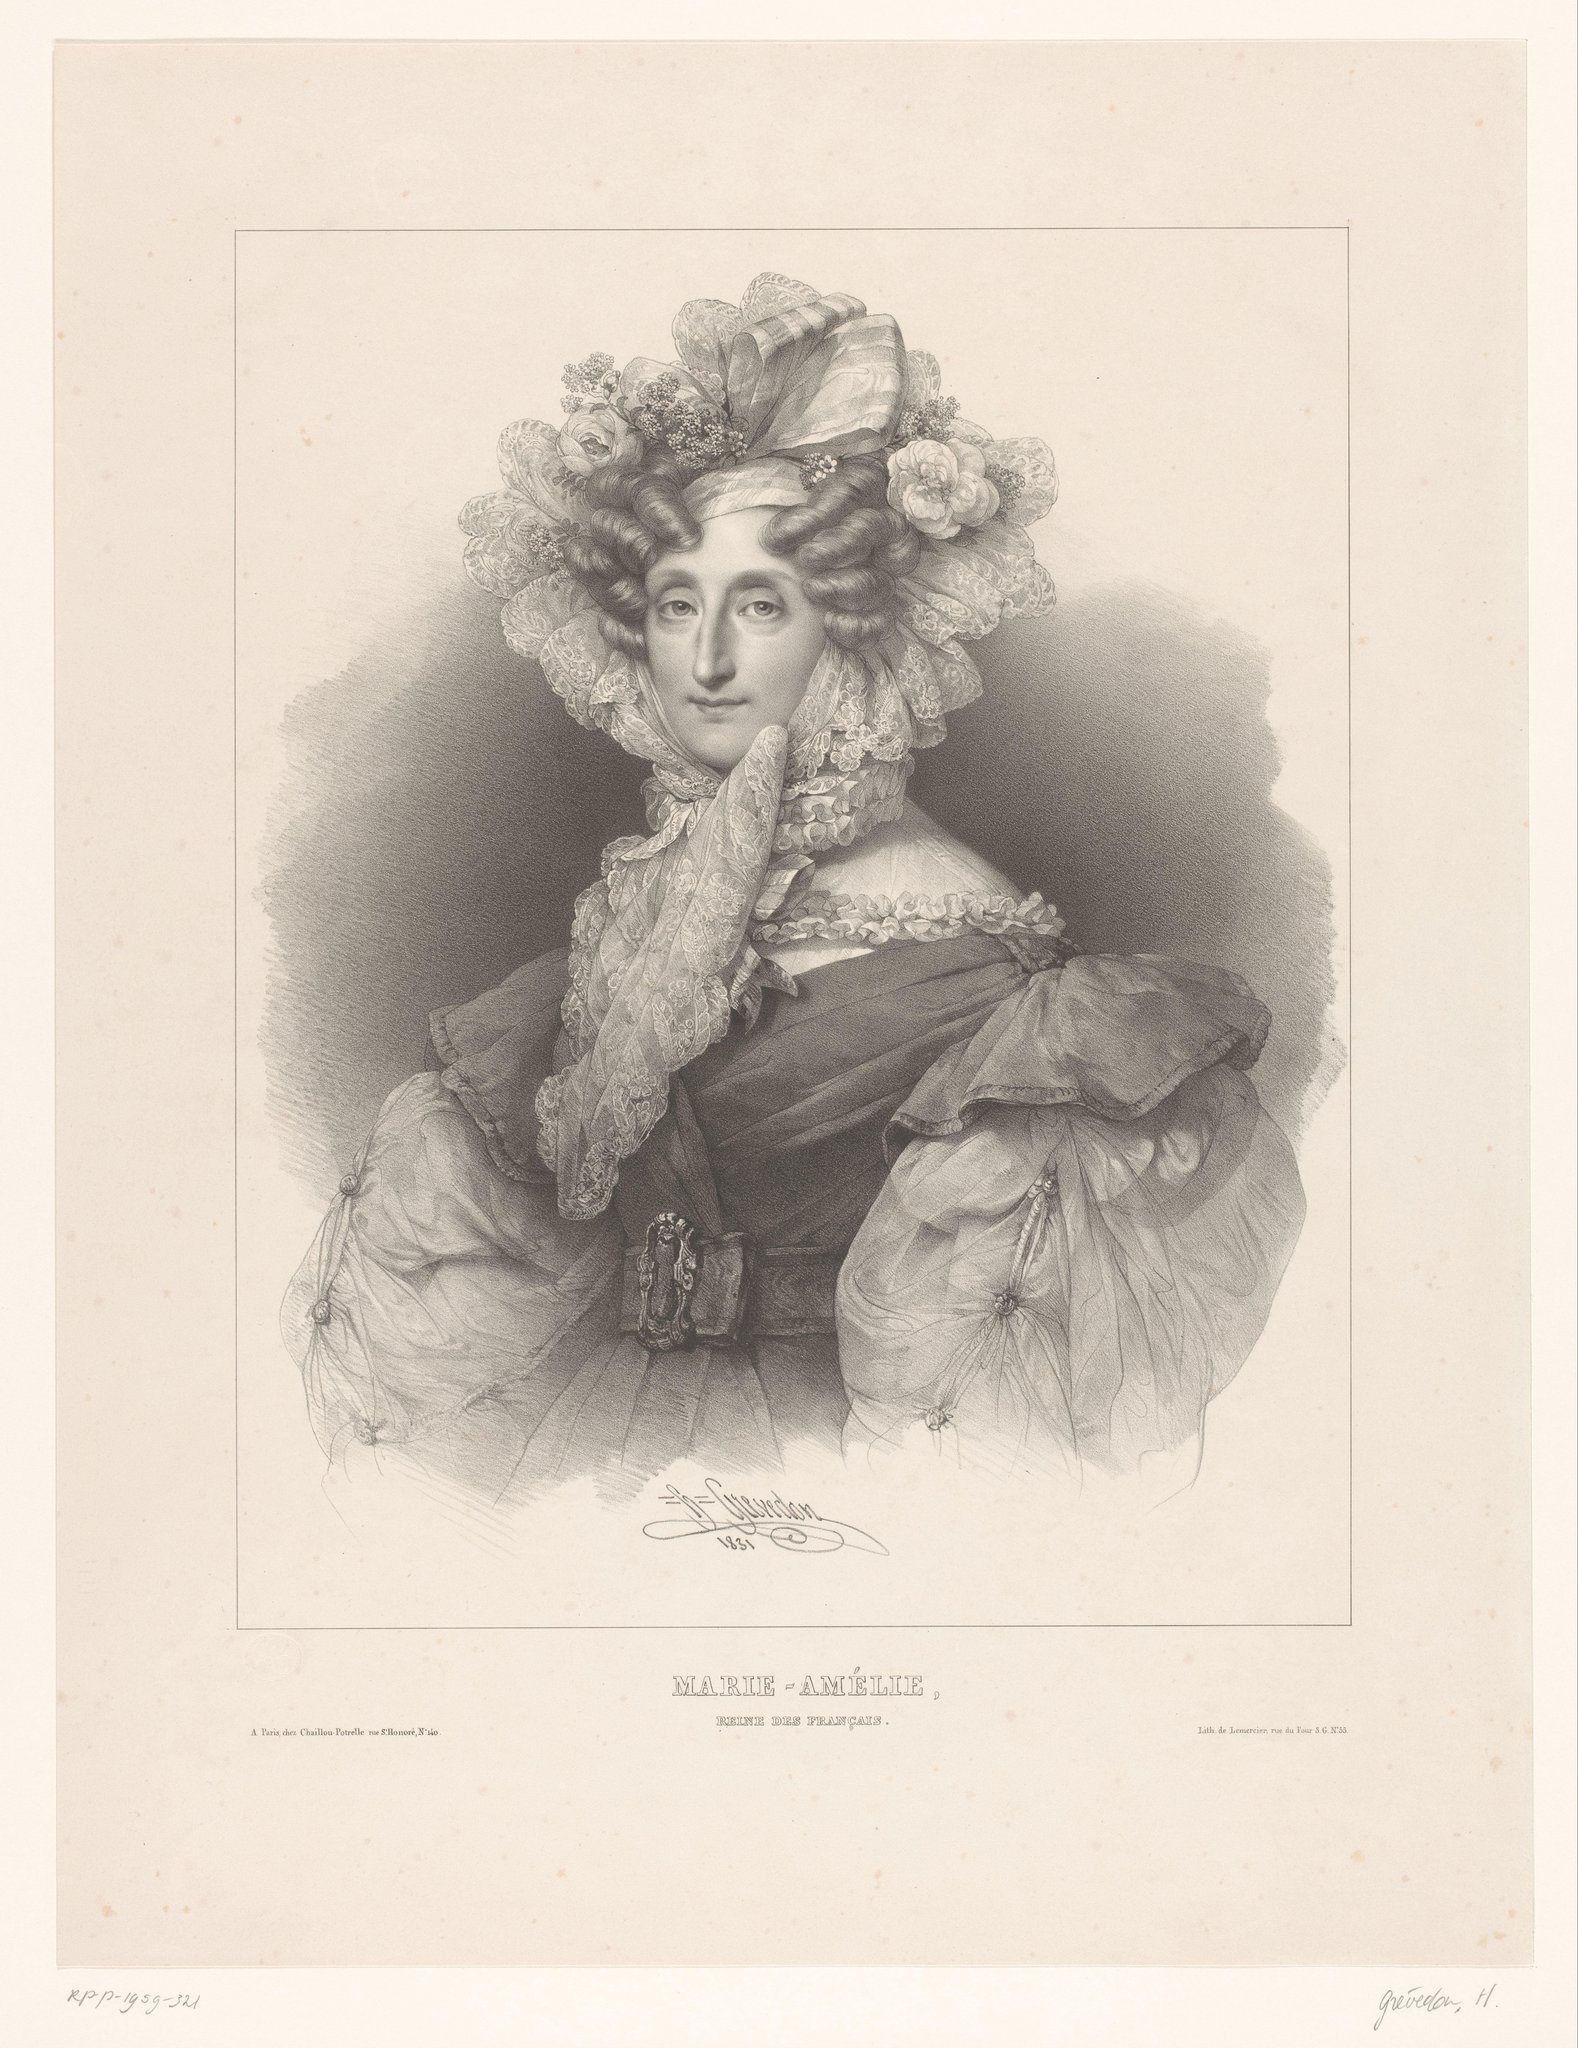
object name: print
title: Portret van Maria Amalia van Bourbon-Sicilië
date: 1831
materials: paper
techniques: lithograph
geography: paris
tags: caserta, london, historical persons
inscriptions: collector's mark: Lugt 2760, check stamp: Lugt 619, collector's mark: Lugt 2228a